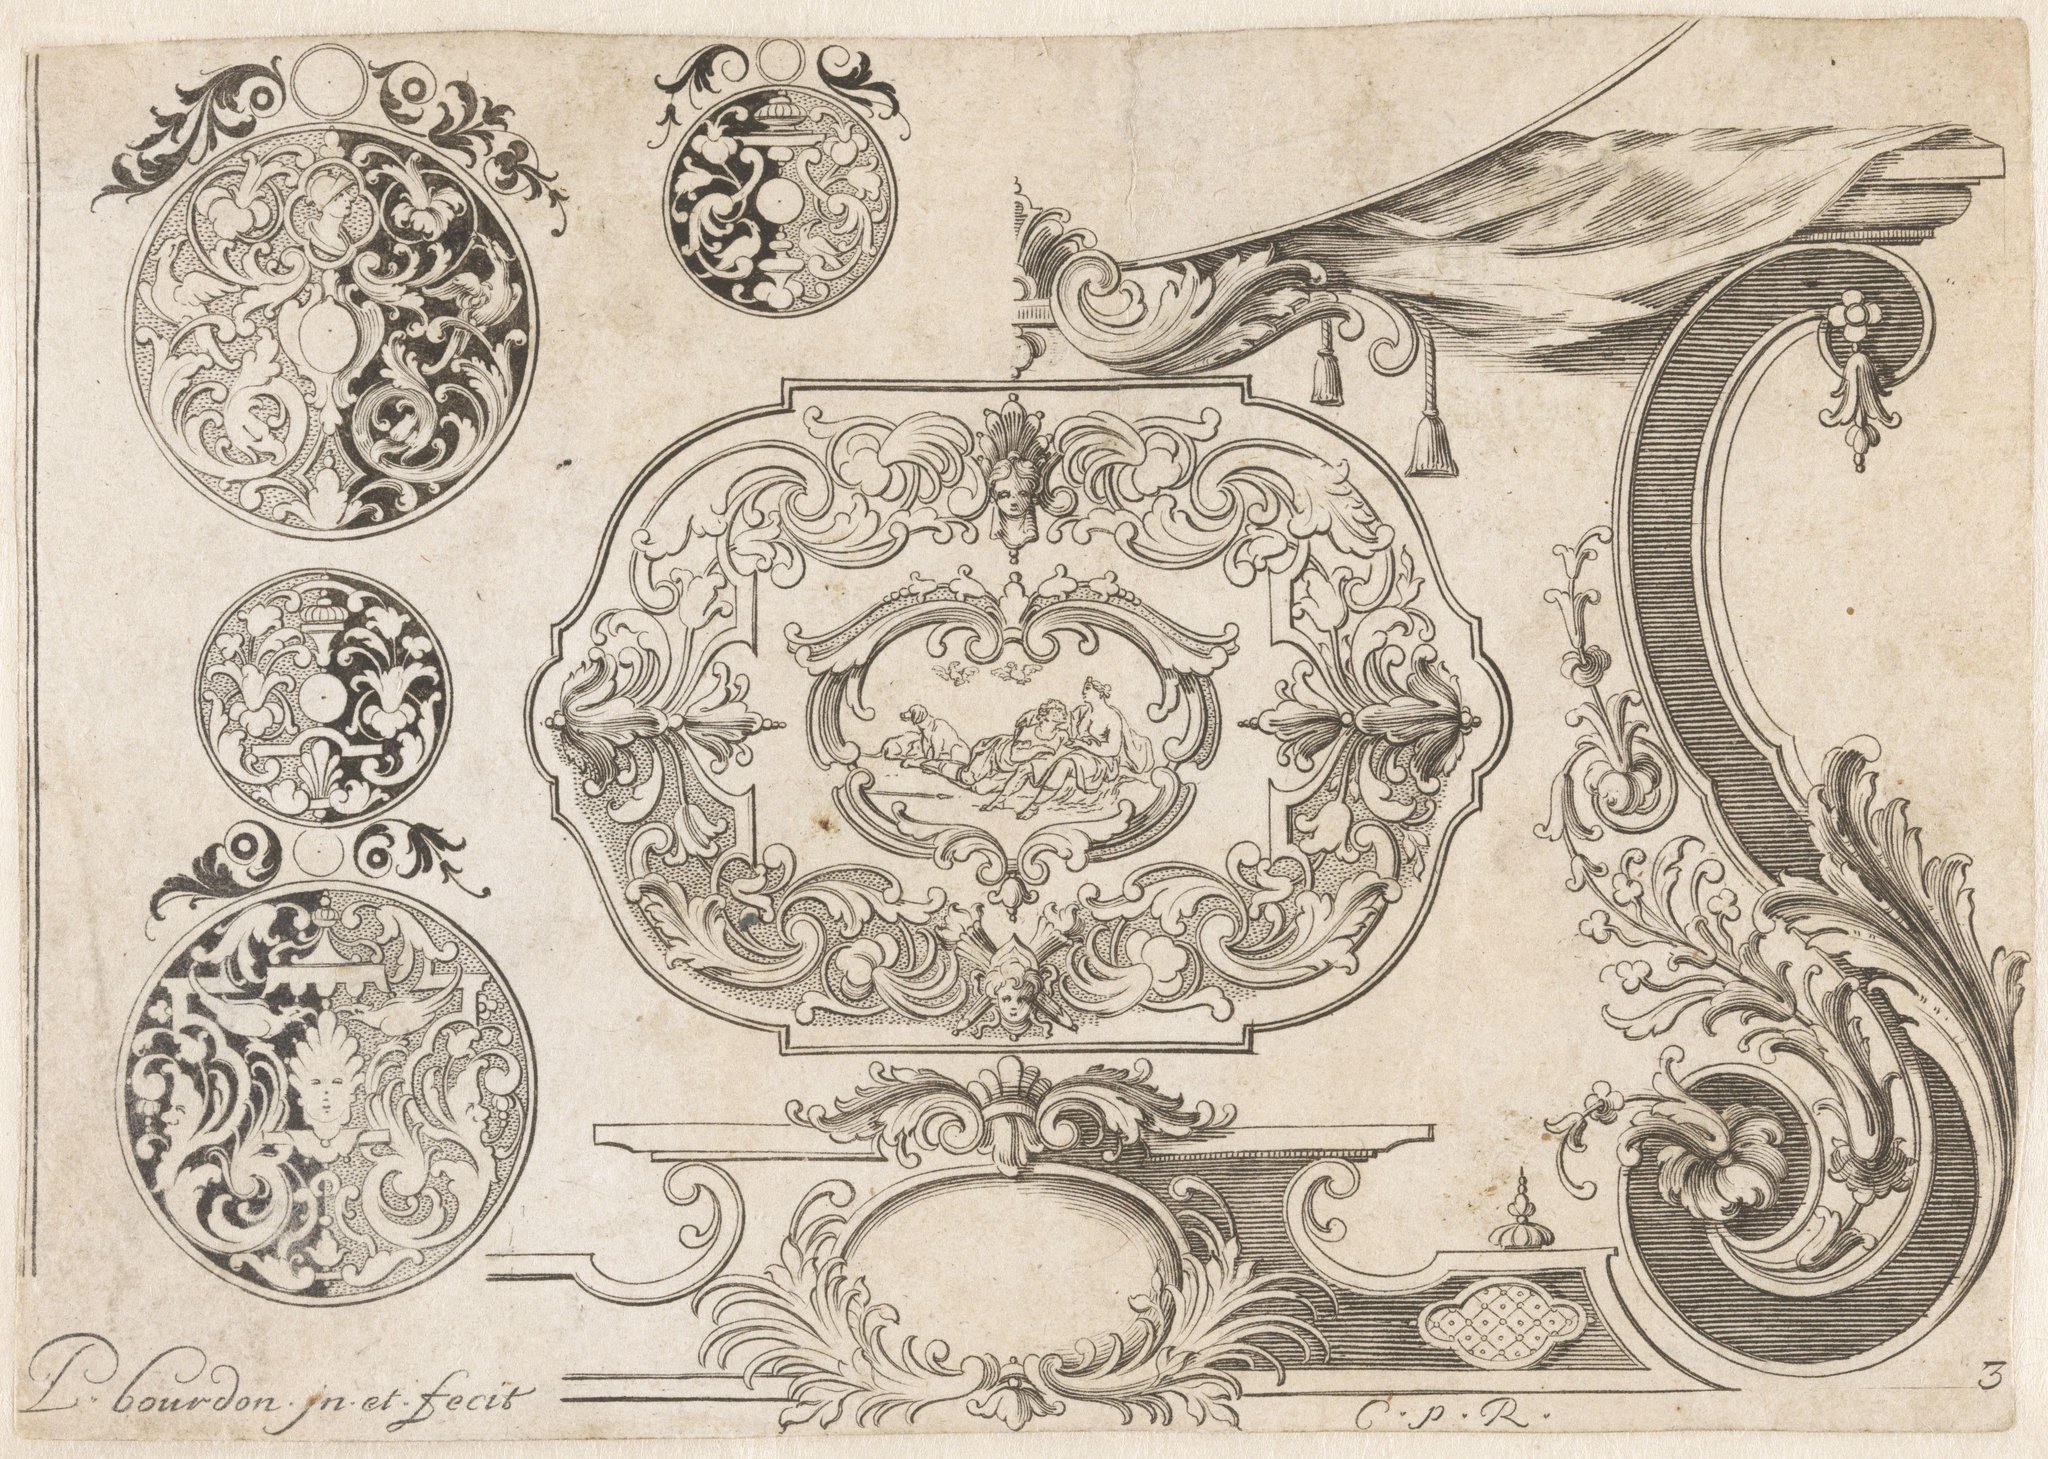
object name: print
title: Livre Premier: Essais de gravure par Pierre Bourdon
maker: pierre bourdon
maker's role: print maker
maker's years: 1656-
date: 1703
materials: paper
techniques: engraving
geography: paris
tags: ornaments ~ art, watch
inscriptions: number: ‘3’, collector's mark: Lugt 2228, collector's mark: Lugt 2760, signature: ‘P. bourdon in et fecit’, privilege: ‘C.P.R.’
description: Blad uit serie van zeven van ontwerpen voor horlogemakers, goudsmeden, beeldhouwers en graveurs.